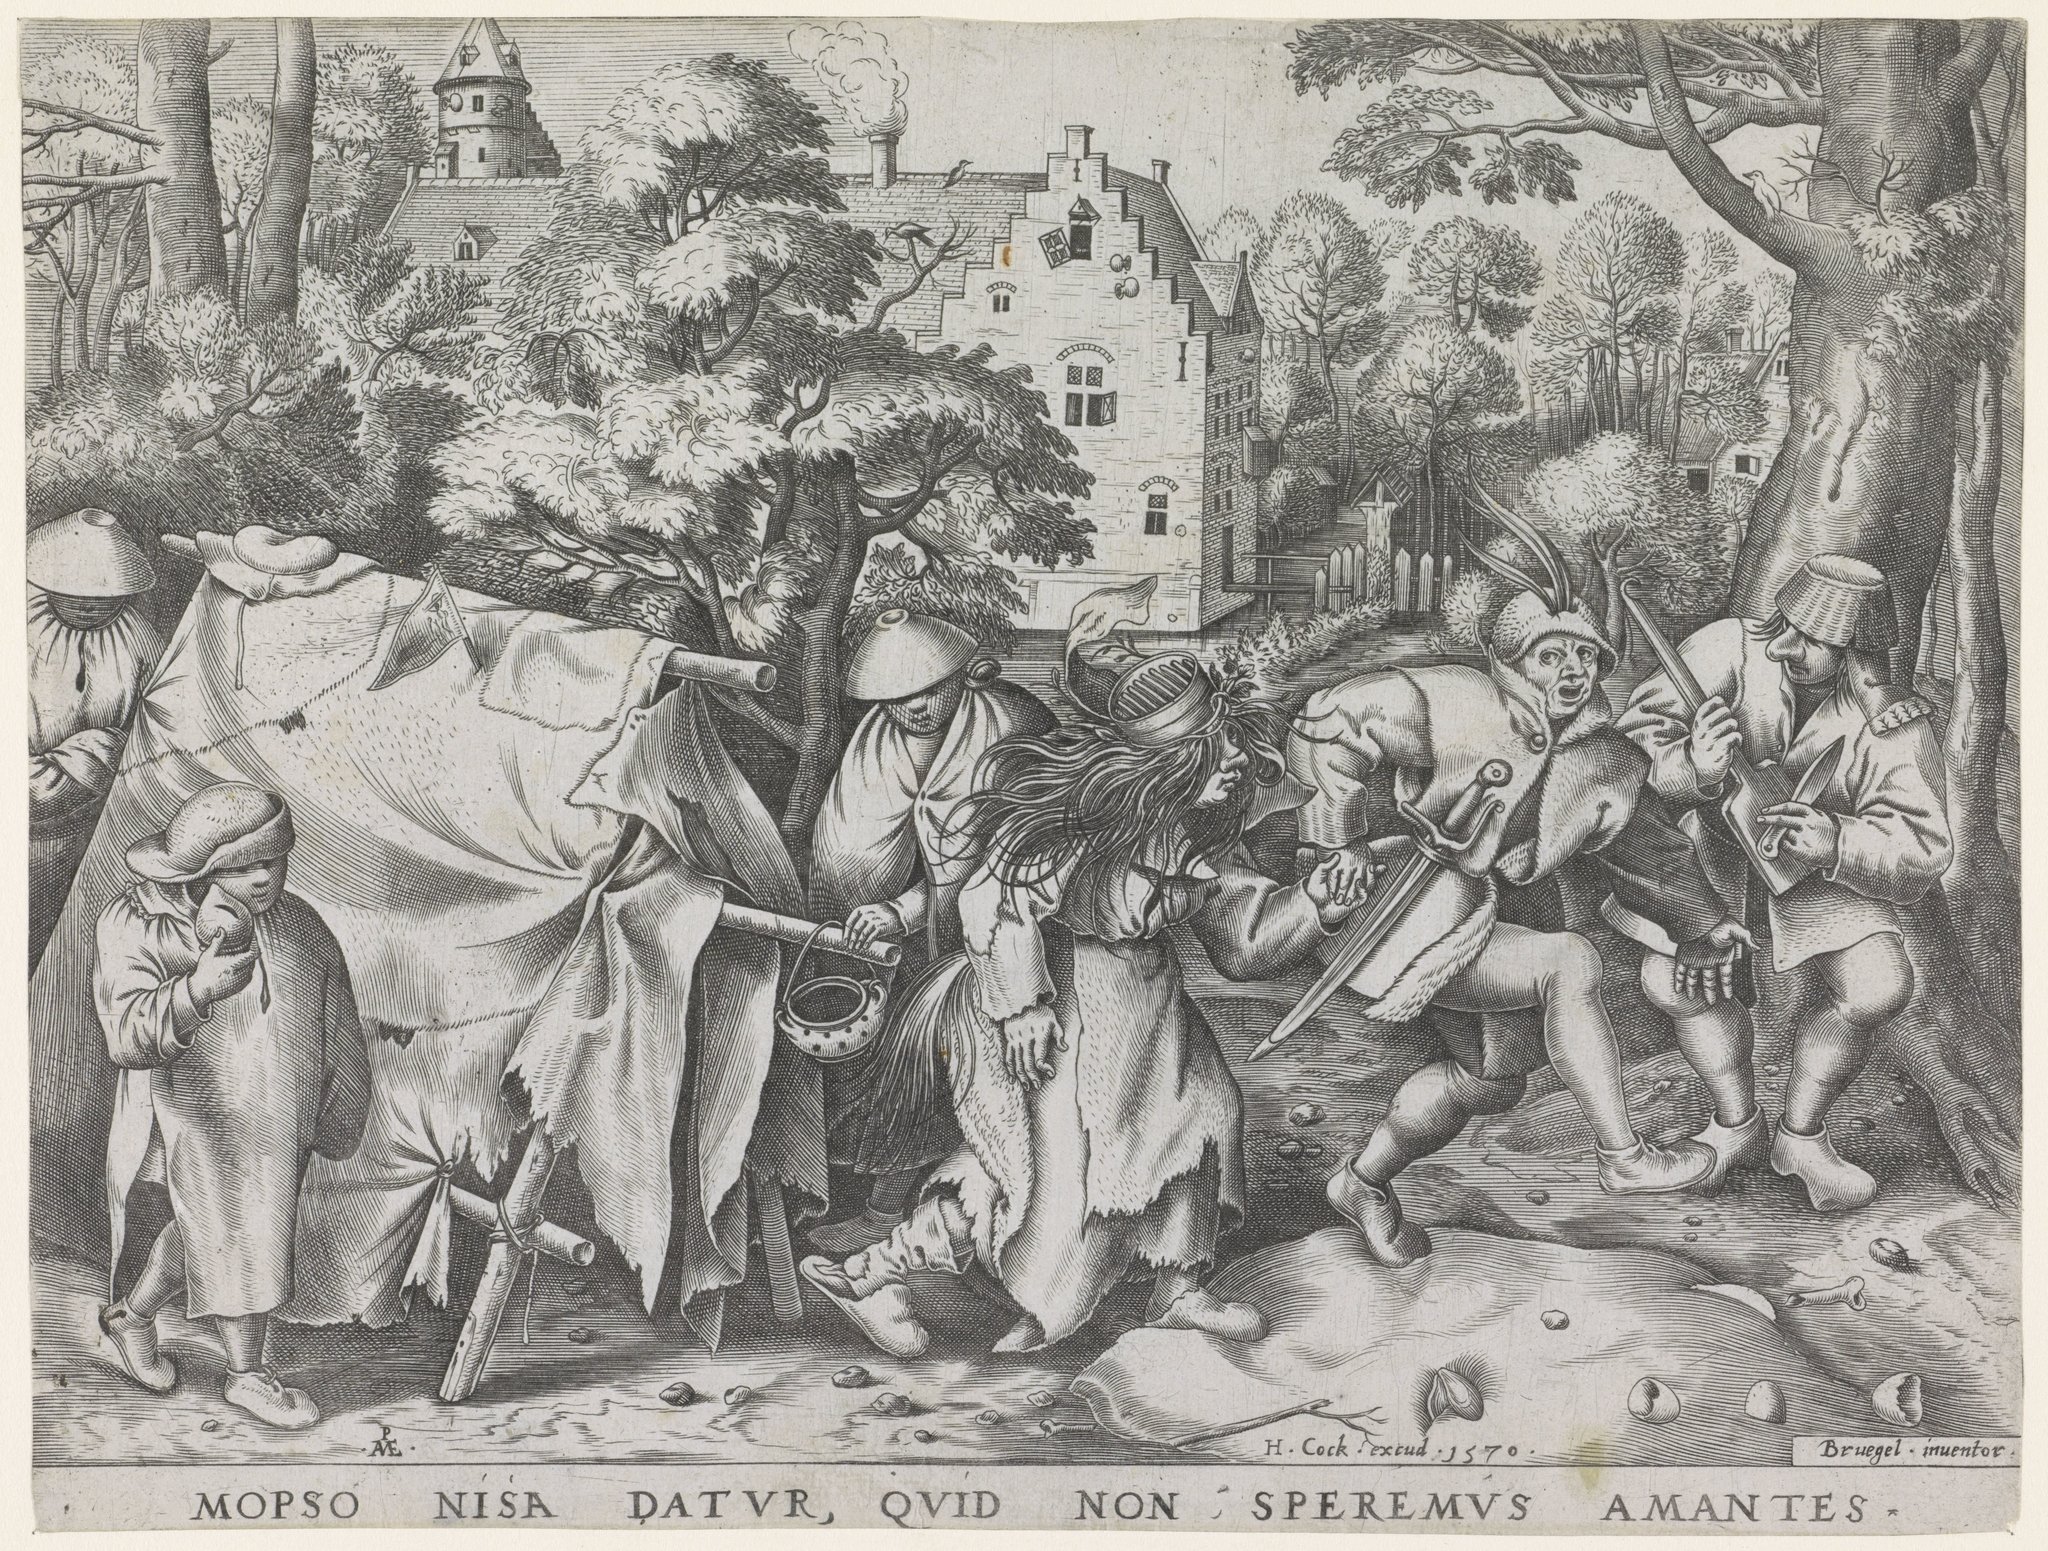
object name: print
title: Mopso Nisa datur, quid non speremus amantes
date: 1570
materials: paper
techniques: engraving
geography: antwerp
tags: tent, dancing at wedding feast, comedy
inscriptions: collector's mark: Lugt 789A, monogram: ‘PAVE’ monogram Van der Heijden, signature: ‘Bruegel.inventor’, address and date: ‘H. Cock excud. 1570’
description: Het komische volksspel De vuile bruid of De bruiloft van Mopsus en Nisa werd in de dagen voor Aswoensdag gespeeld. Het verhaal van de bruiloft van Mopsus en Nisa is afkomstig uit de dichtbundel Bucolica of Eclogen van de Romeinse dichter Vergilius, maar verscheen ook in contemporaine verzen, waarin het verhaal gebruikt werd om de omgekeerde wereld weer te geven. Het onderschrift in het Latijn, vers 26 uit Ecloge VIII van Vergilius, betekent vrij vertaald 'Mopsus trouwt Nisa, wat niet is waar geliefden op hopen'. Met andere woorden: alles is mogelijk of alles kan gebeuren. In de zestiende eeuw was dit een gebruikelijk spreekwoord. Het spreekwoord is opgenomen in Sebastian Francks spreekwoordenverzameling uit 1541.